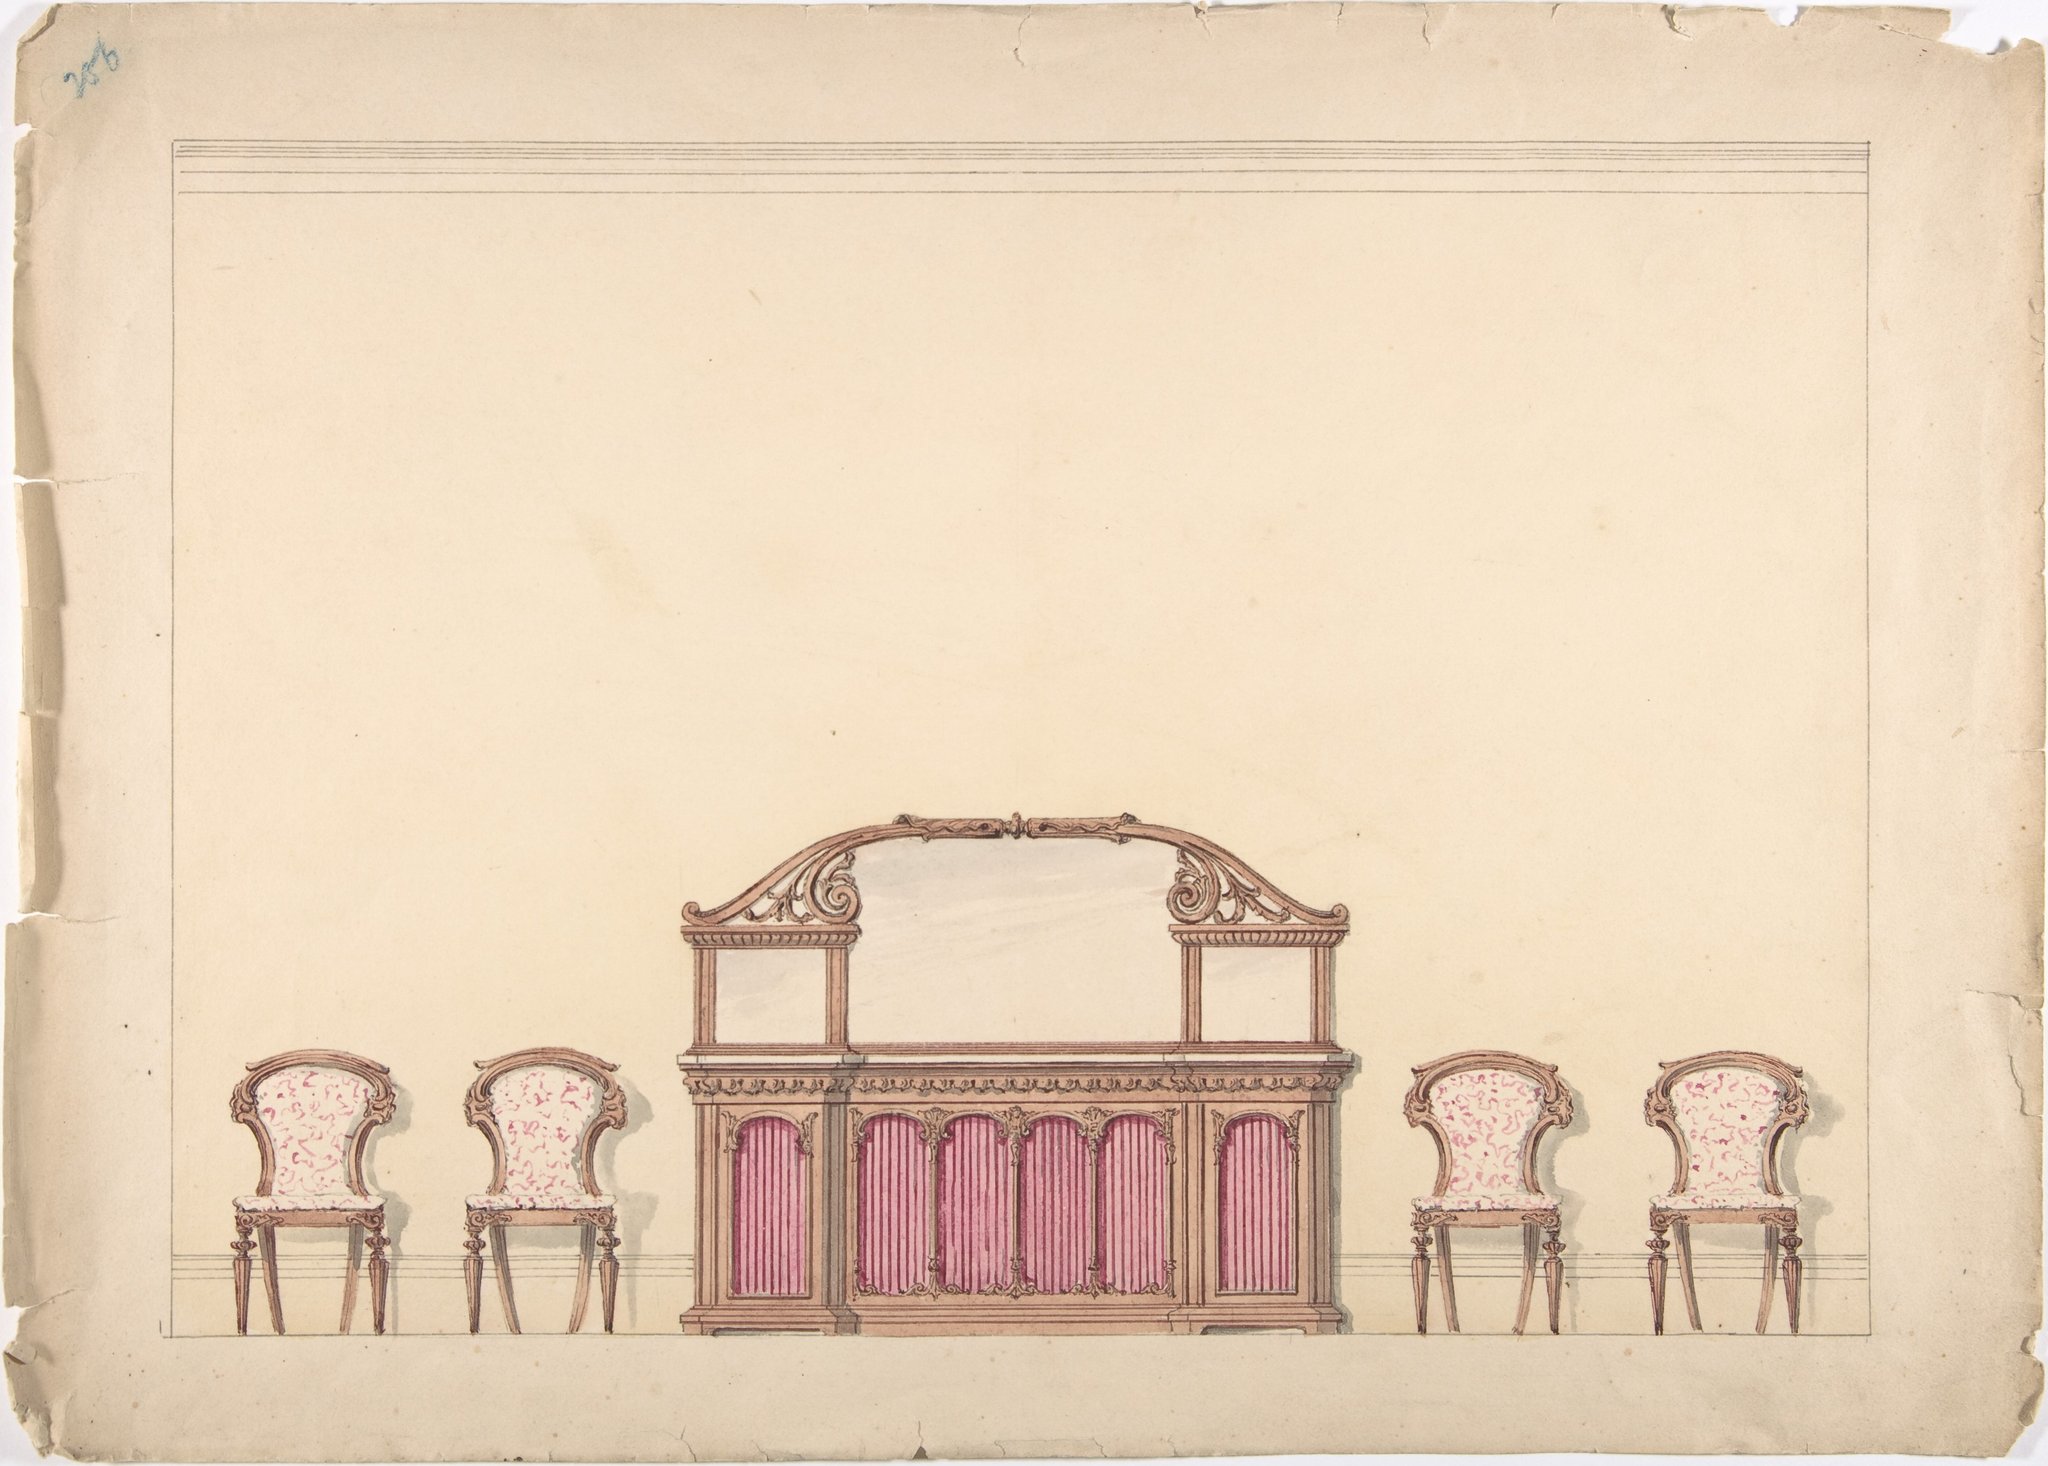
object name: drawing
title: Design for a Mirrored Cabinet and Four Chairs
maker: anonymous, british, 19th century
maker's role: artist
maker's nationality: british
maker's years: 1800-1900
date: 1801-1833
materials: ink, watercolor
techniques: brush, pen, wash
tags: chairs,cabinets,mirrors